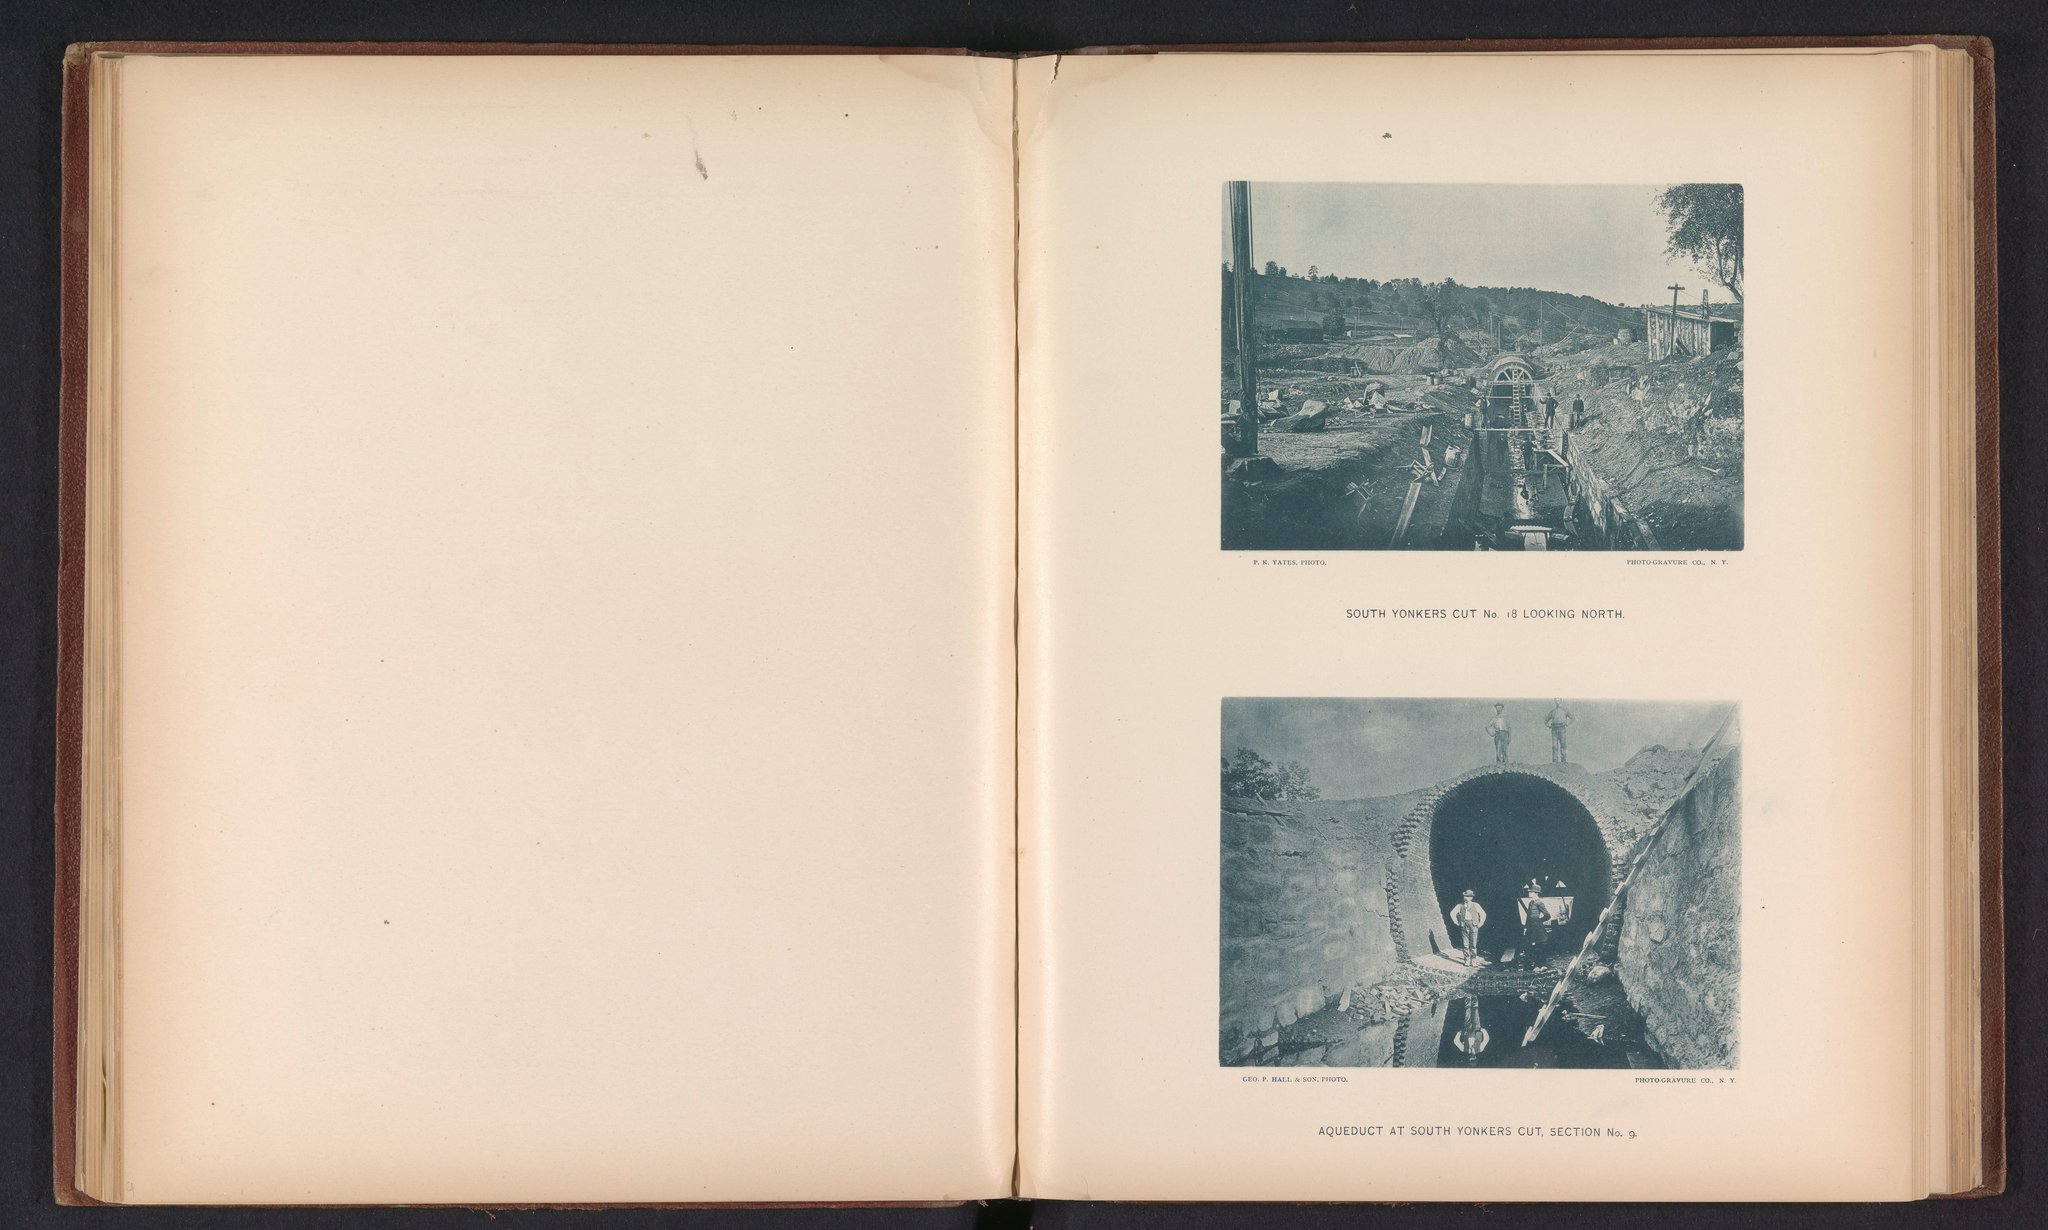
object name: photomechanical print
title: Aqueduct at South Yonkers cut, section no. 9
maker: preston k. yates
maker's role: engineer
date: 1883-1887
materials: paper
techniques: photograph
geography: new york city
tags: aqueduct (~ water supply), building-site